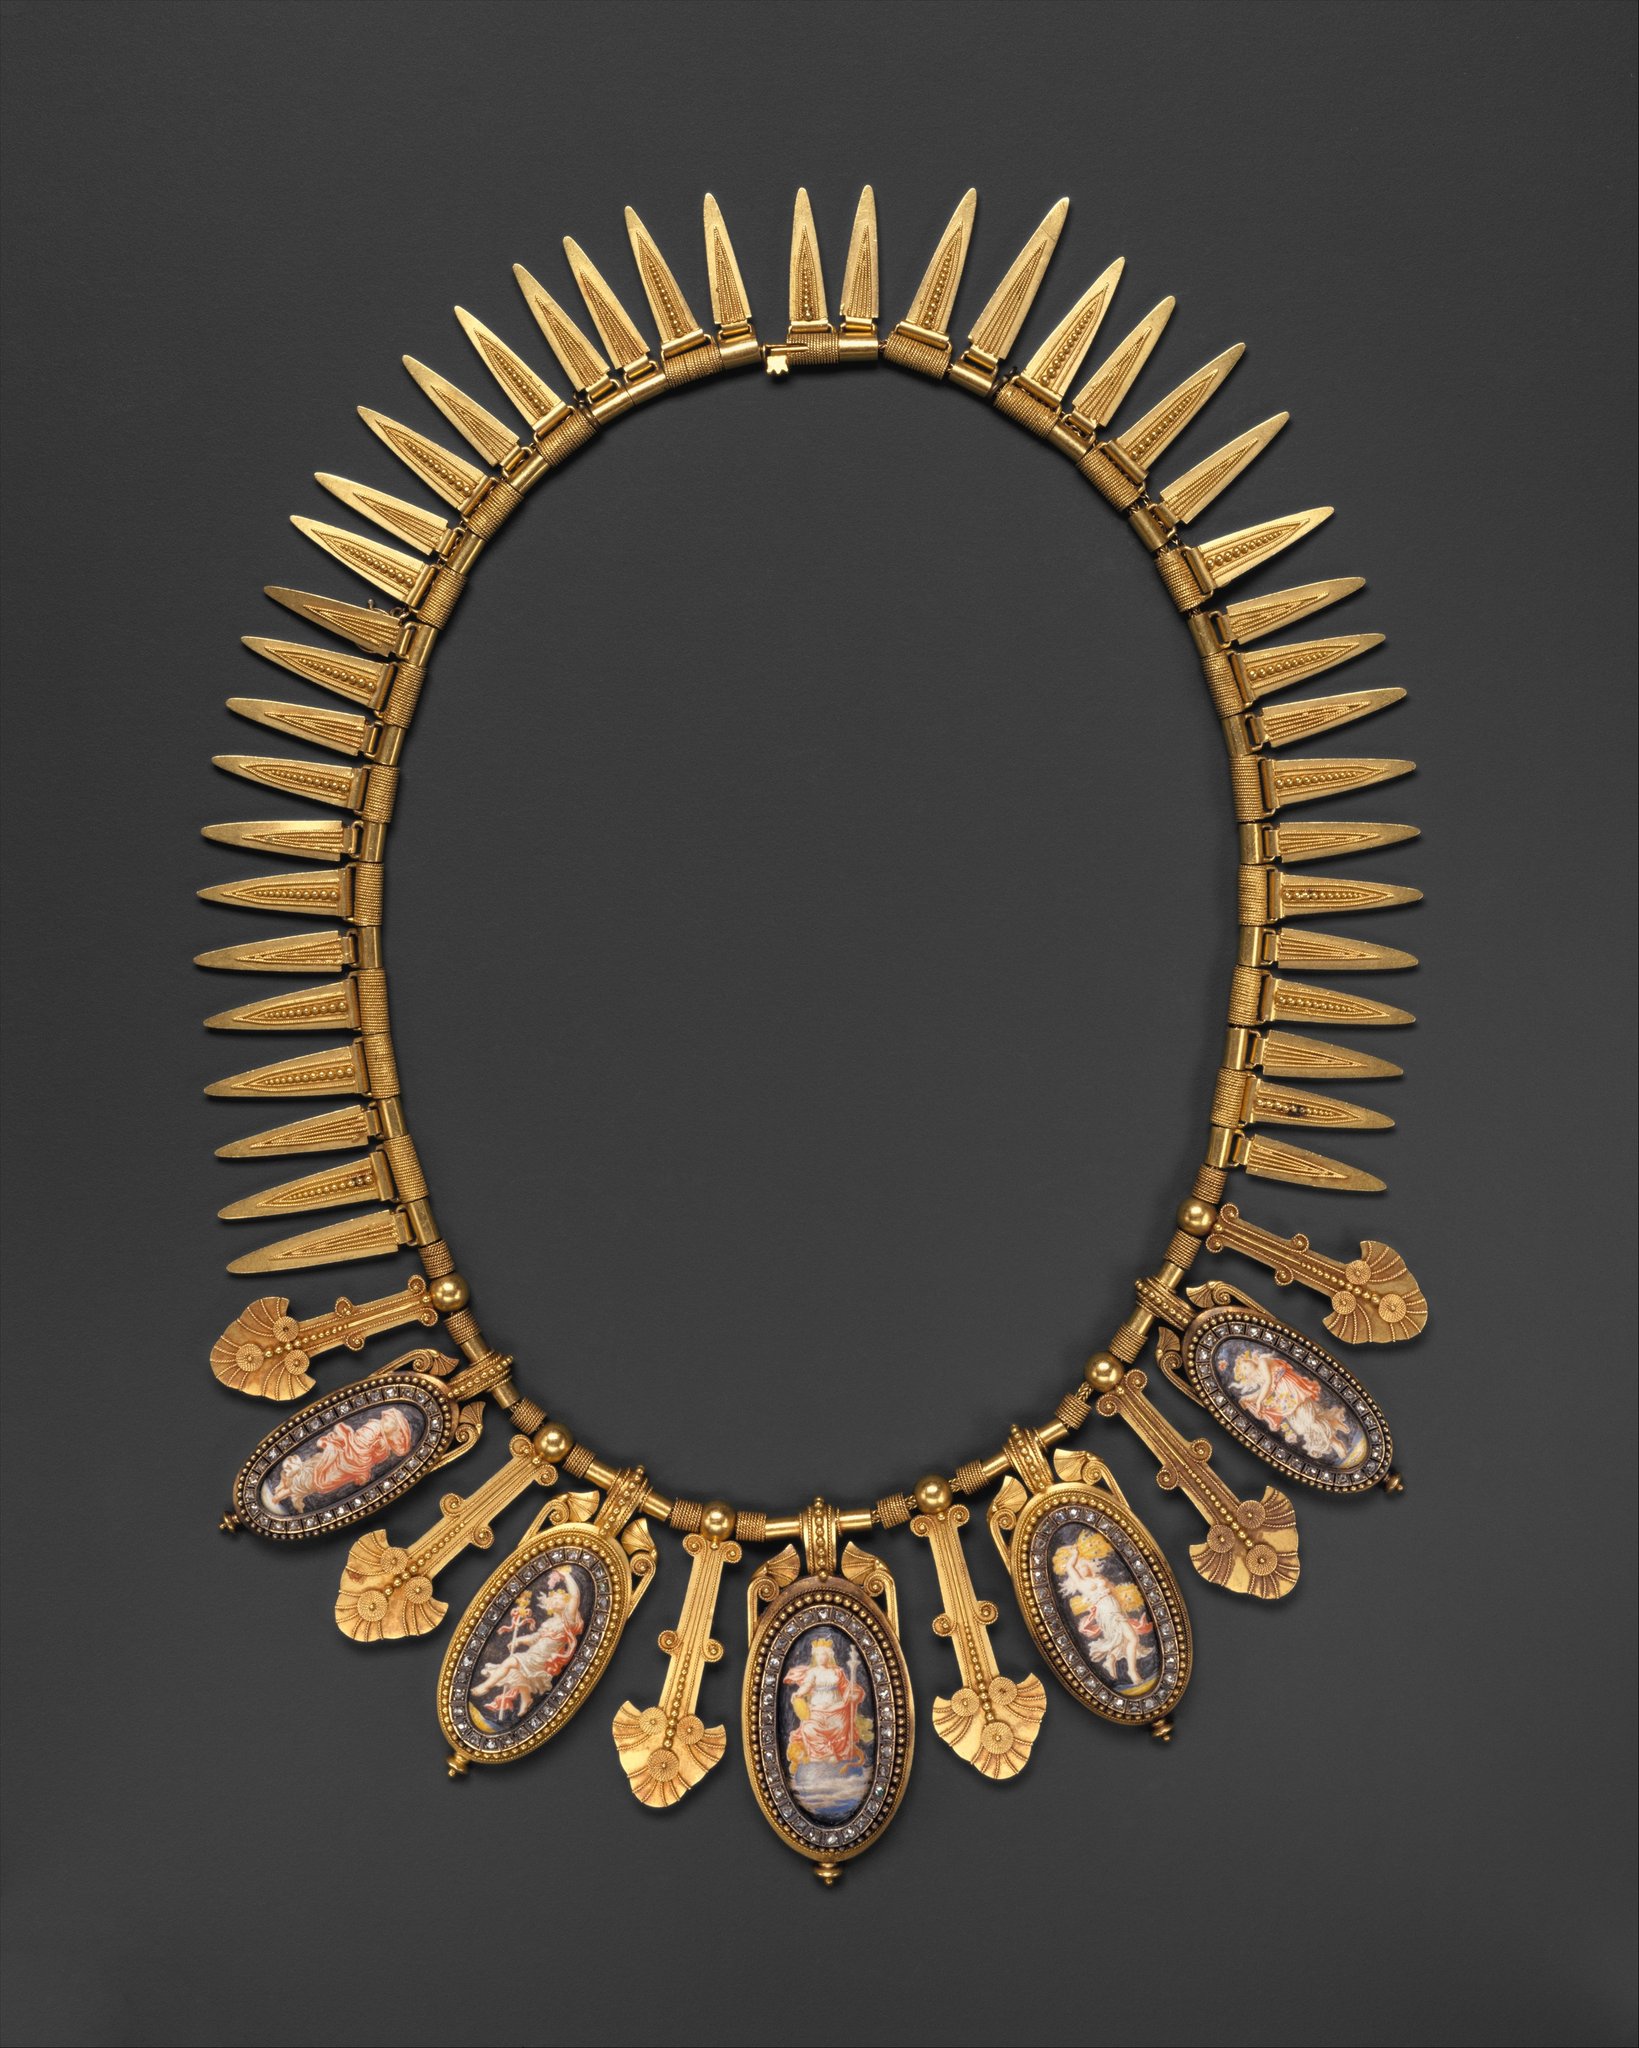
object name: necklace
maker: eugêne fontenay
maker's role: artist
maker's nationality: french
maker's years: 1823-1887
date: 1870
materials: diamond, enamel, gold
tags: women